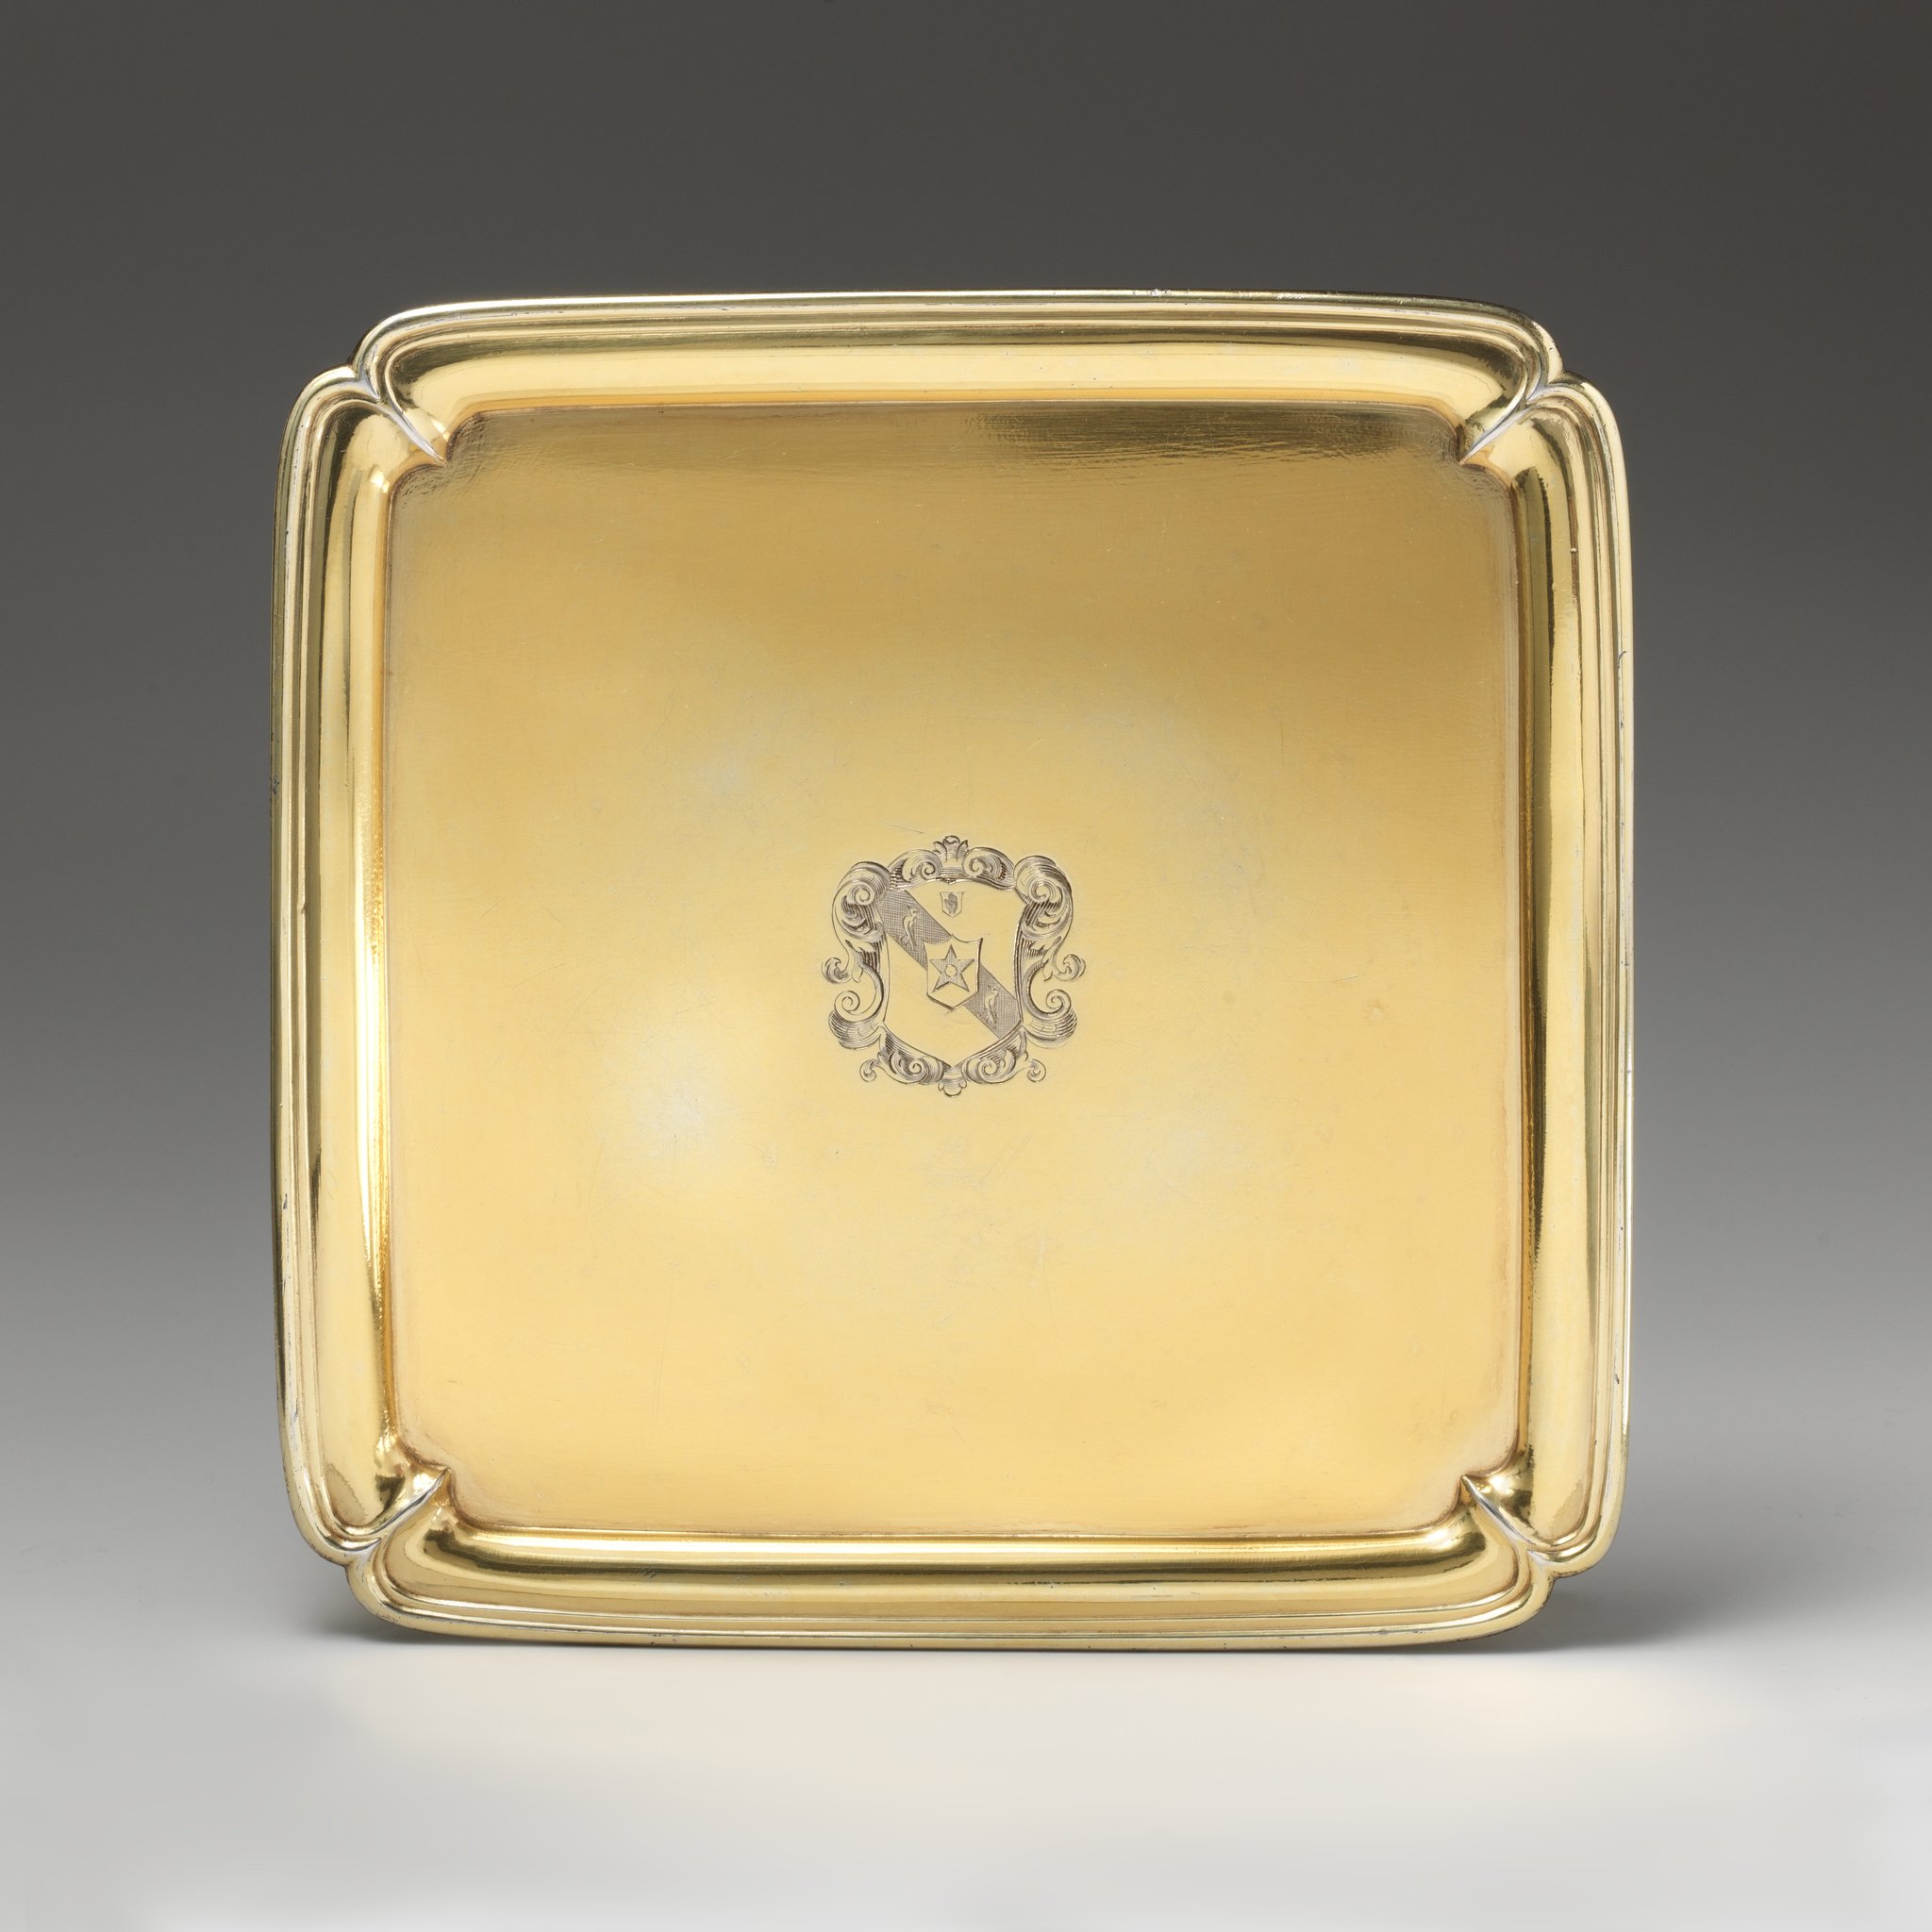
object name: salver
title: Salver (one of a pair)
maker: simon pantin i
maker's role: maker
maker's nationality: british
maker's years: 1672-1728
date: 1727-1728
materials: silver gilt